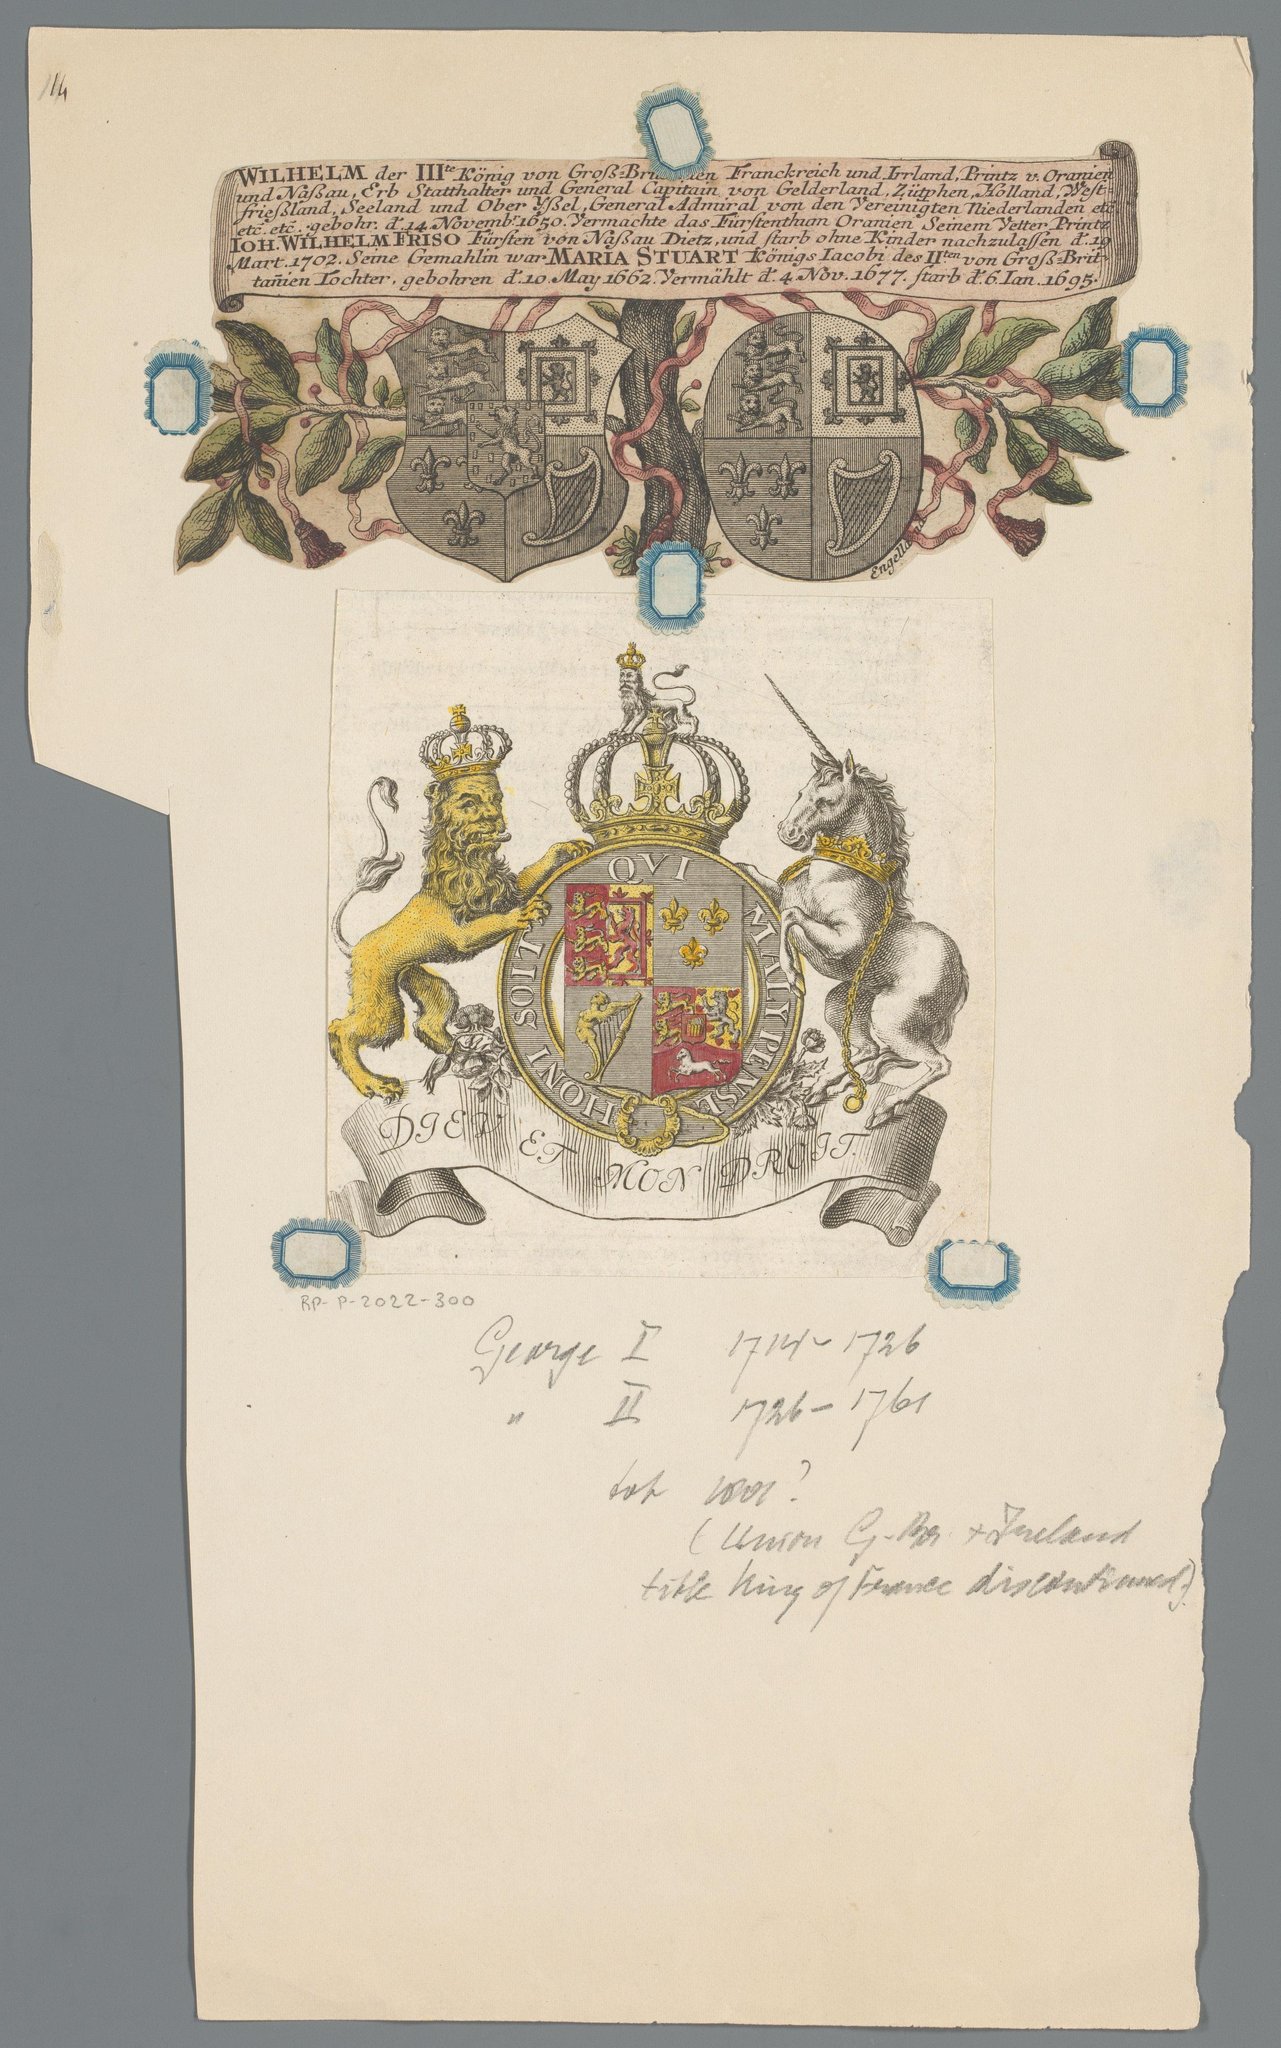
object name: print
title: Wilhelm der IIIte König van Gross-Bittanien Franckreich und Irrland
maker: Anonymous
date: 1700-1749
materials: paper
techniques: engraving, etching, hand coloring, letterpress printing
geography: nuremberg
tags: the hague, william iii (prince of orange and king of england, scotland, and ireland), london, maria ii stuart (koningin van engeland, schotland en ierland), armorial bearing, heraldry, great britain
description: Onderste prent uit: Der durchlauchtigen Welt (...) Geschichts-Geschlechts- und Wappen-Kalender (...). Neurenberg: erven Christoph Weigel, 1746.